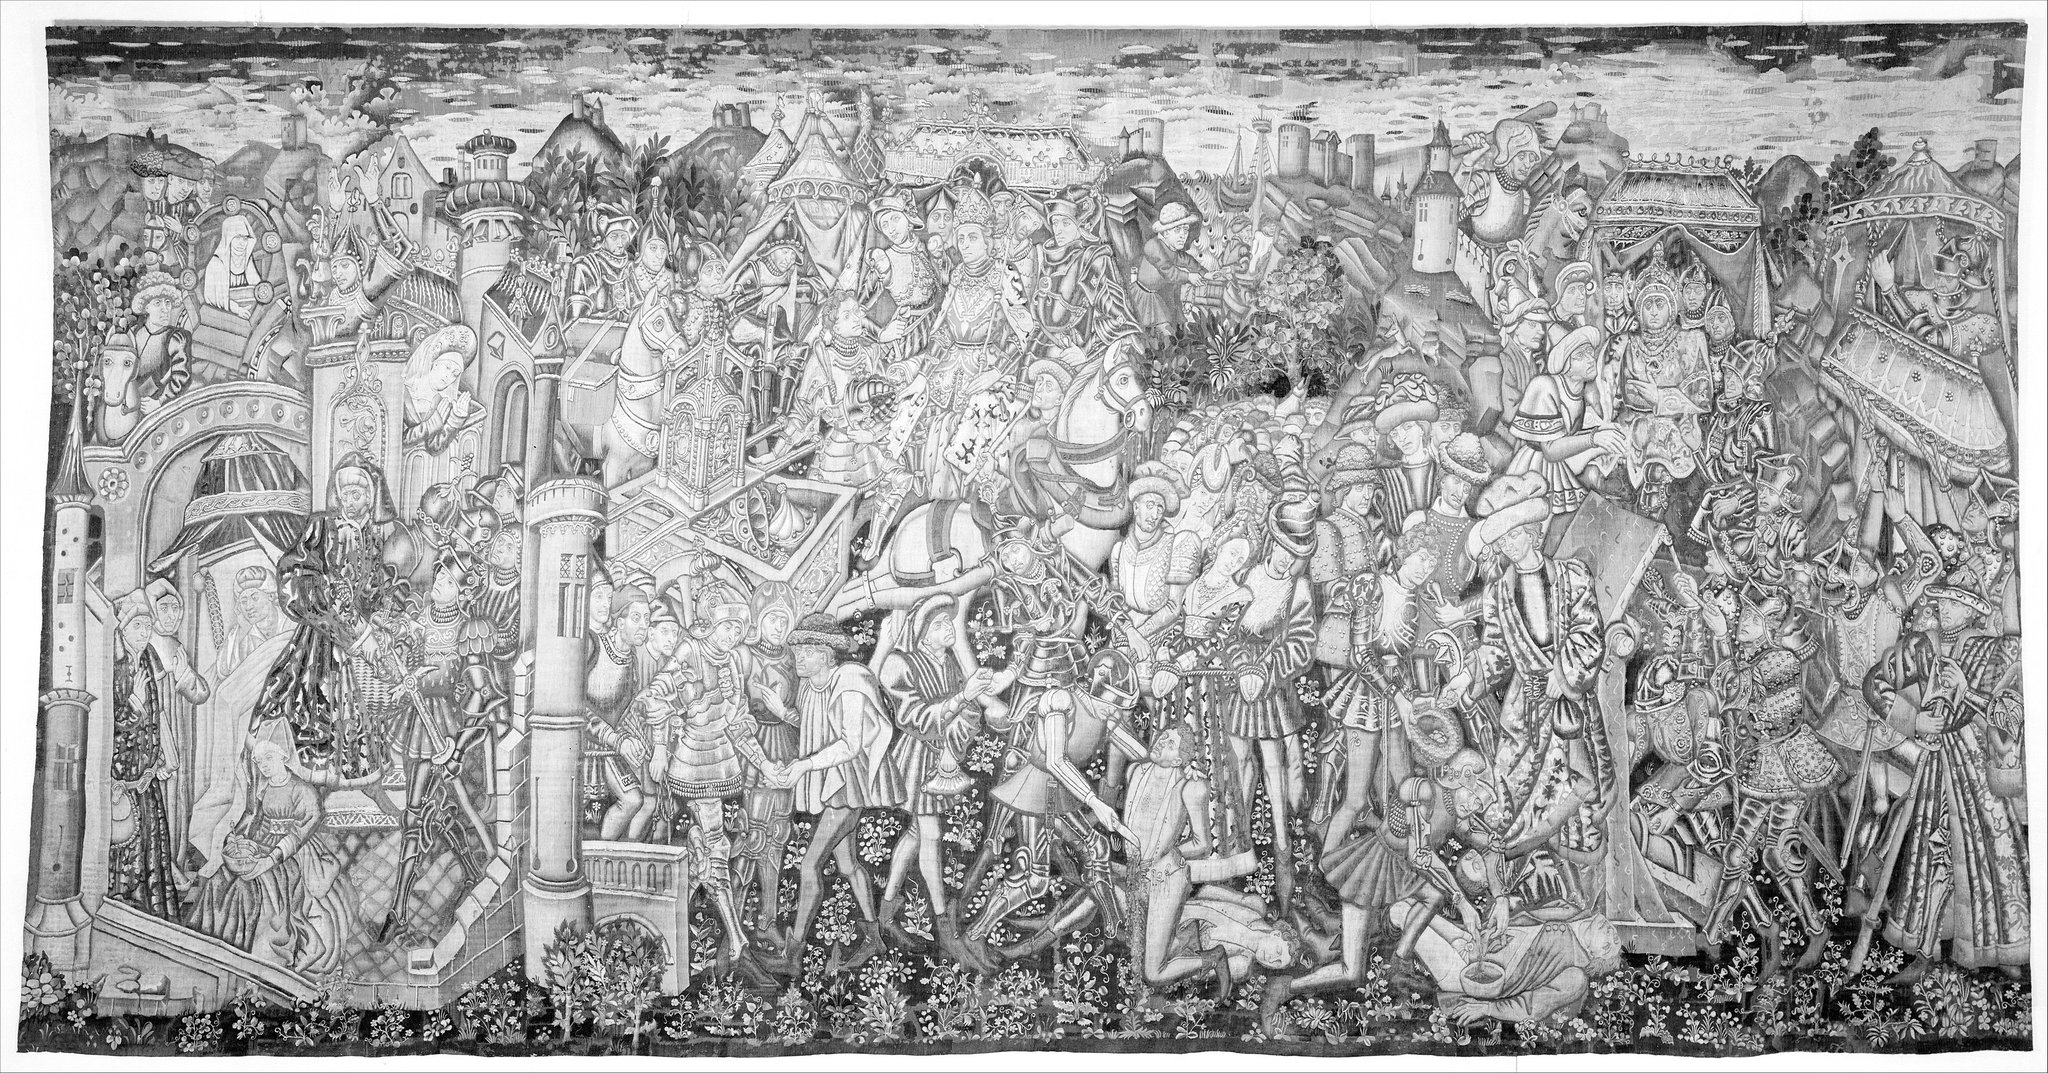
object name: tapestry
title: Episodes in the Story of the Vengeance of Our Lord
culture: south netherlandish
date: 1460-1470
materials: silk, wool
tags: soldiers,women,horses